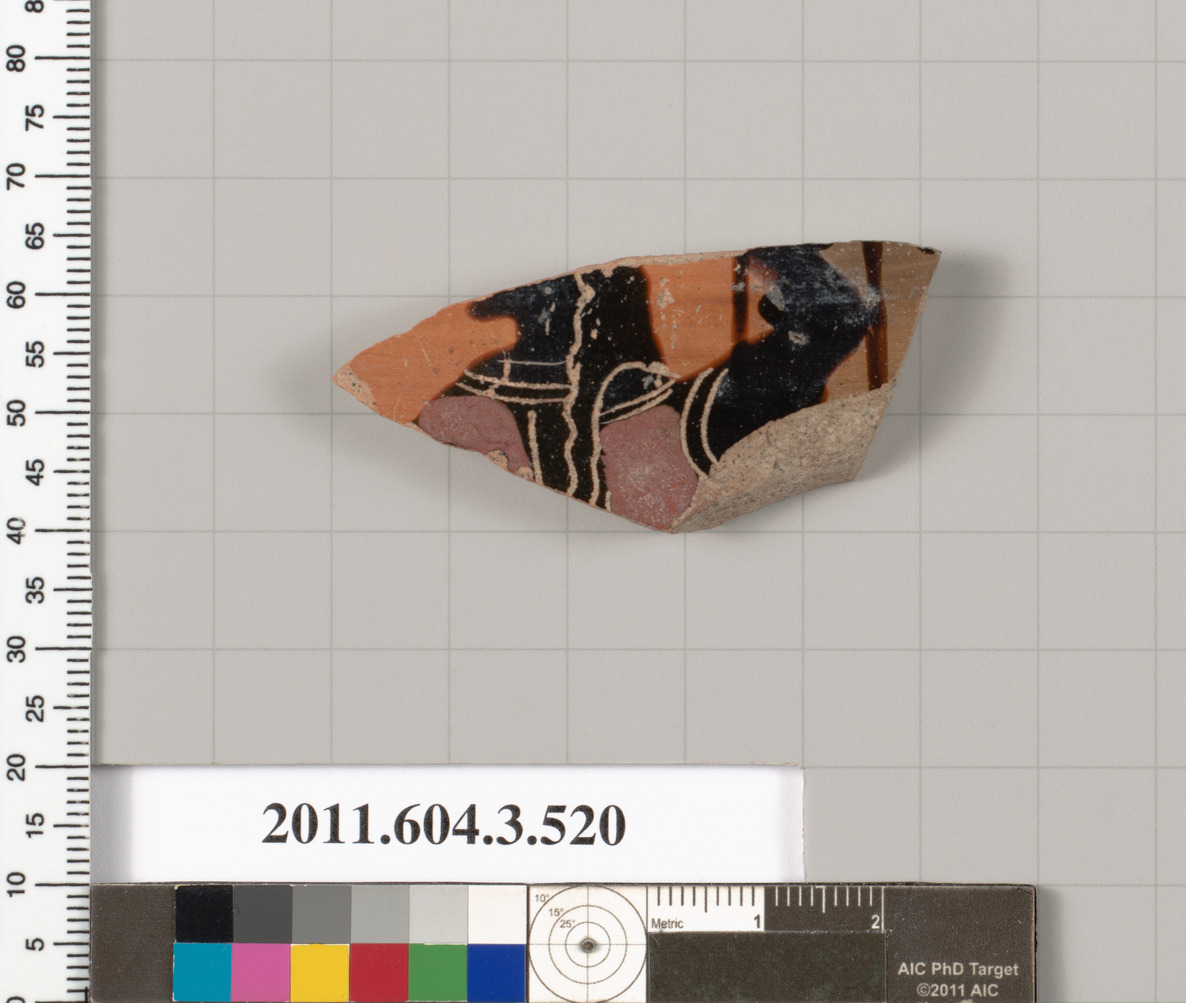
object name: column krater fragment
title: Terracotta fragment of a column-krater (bowl for mixing wine and water)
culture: greek, attic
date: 510 BCE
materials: terracotta